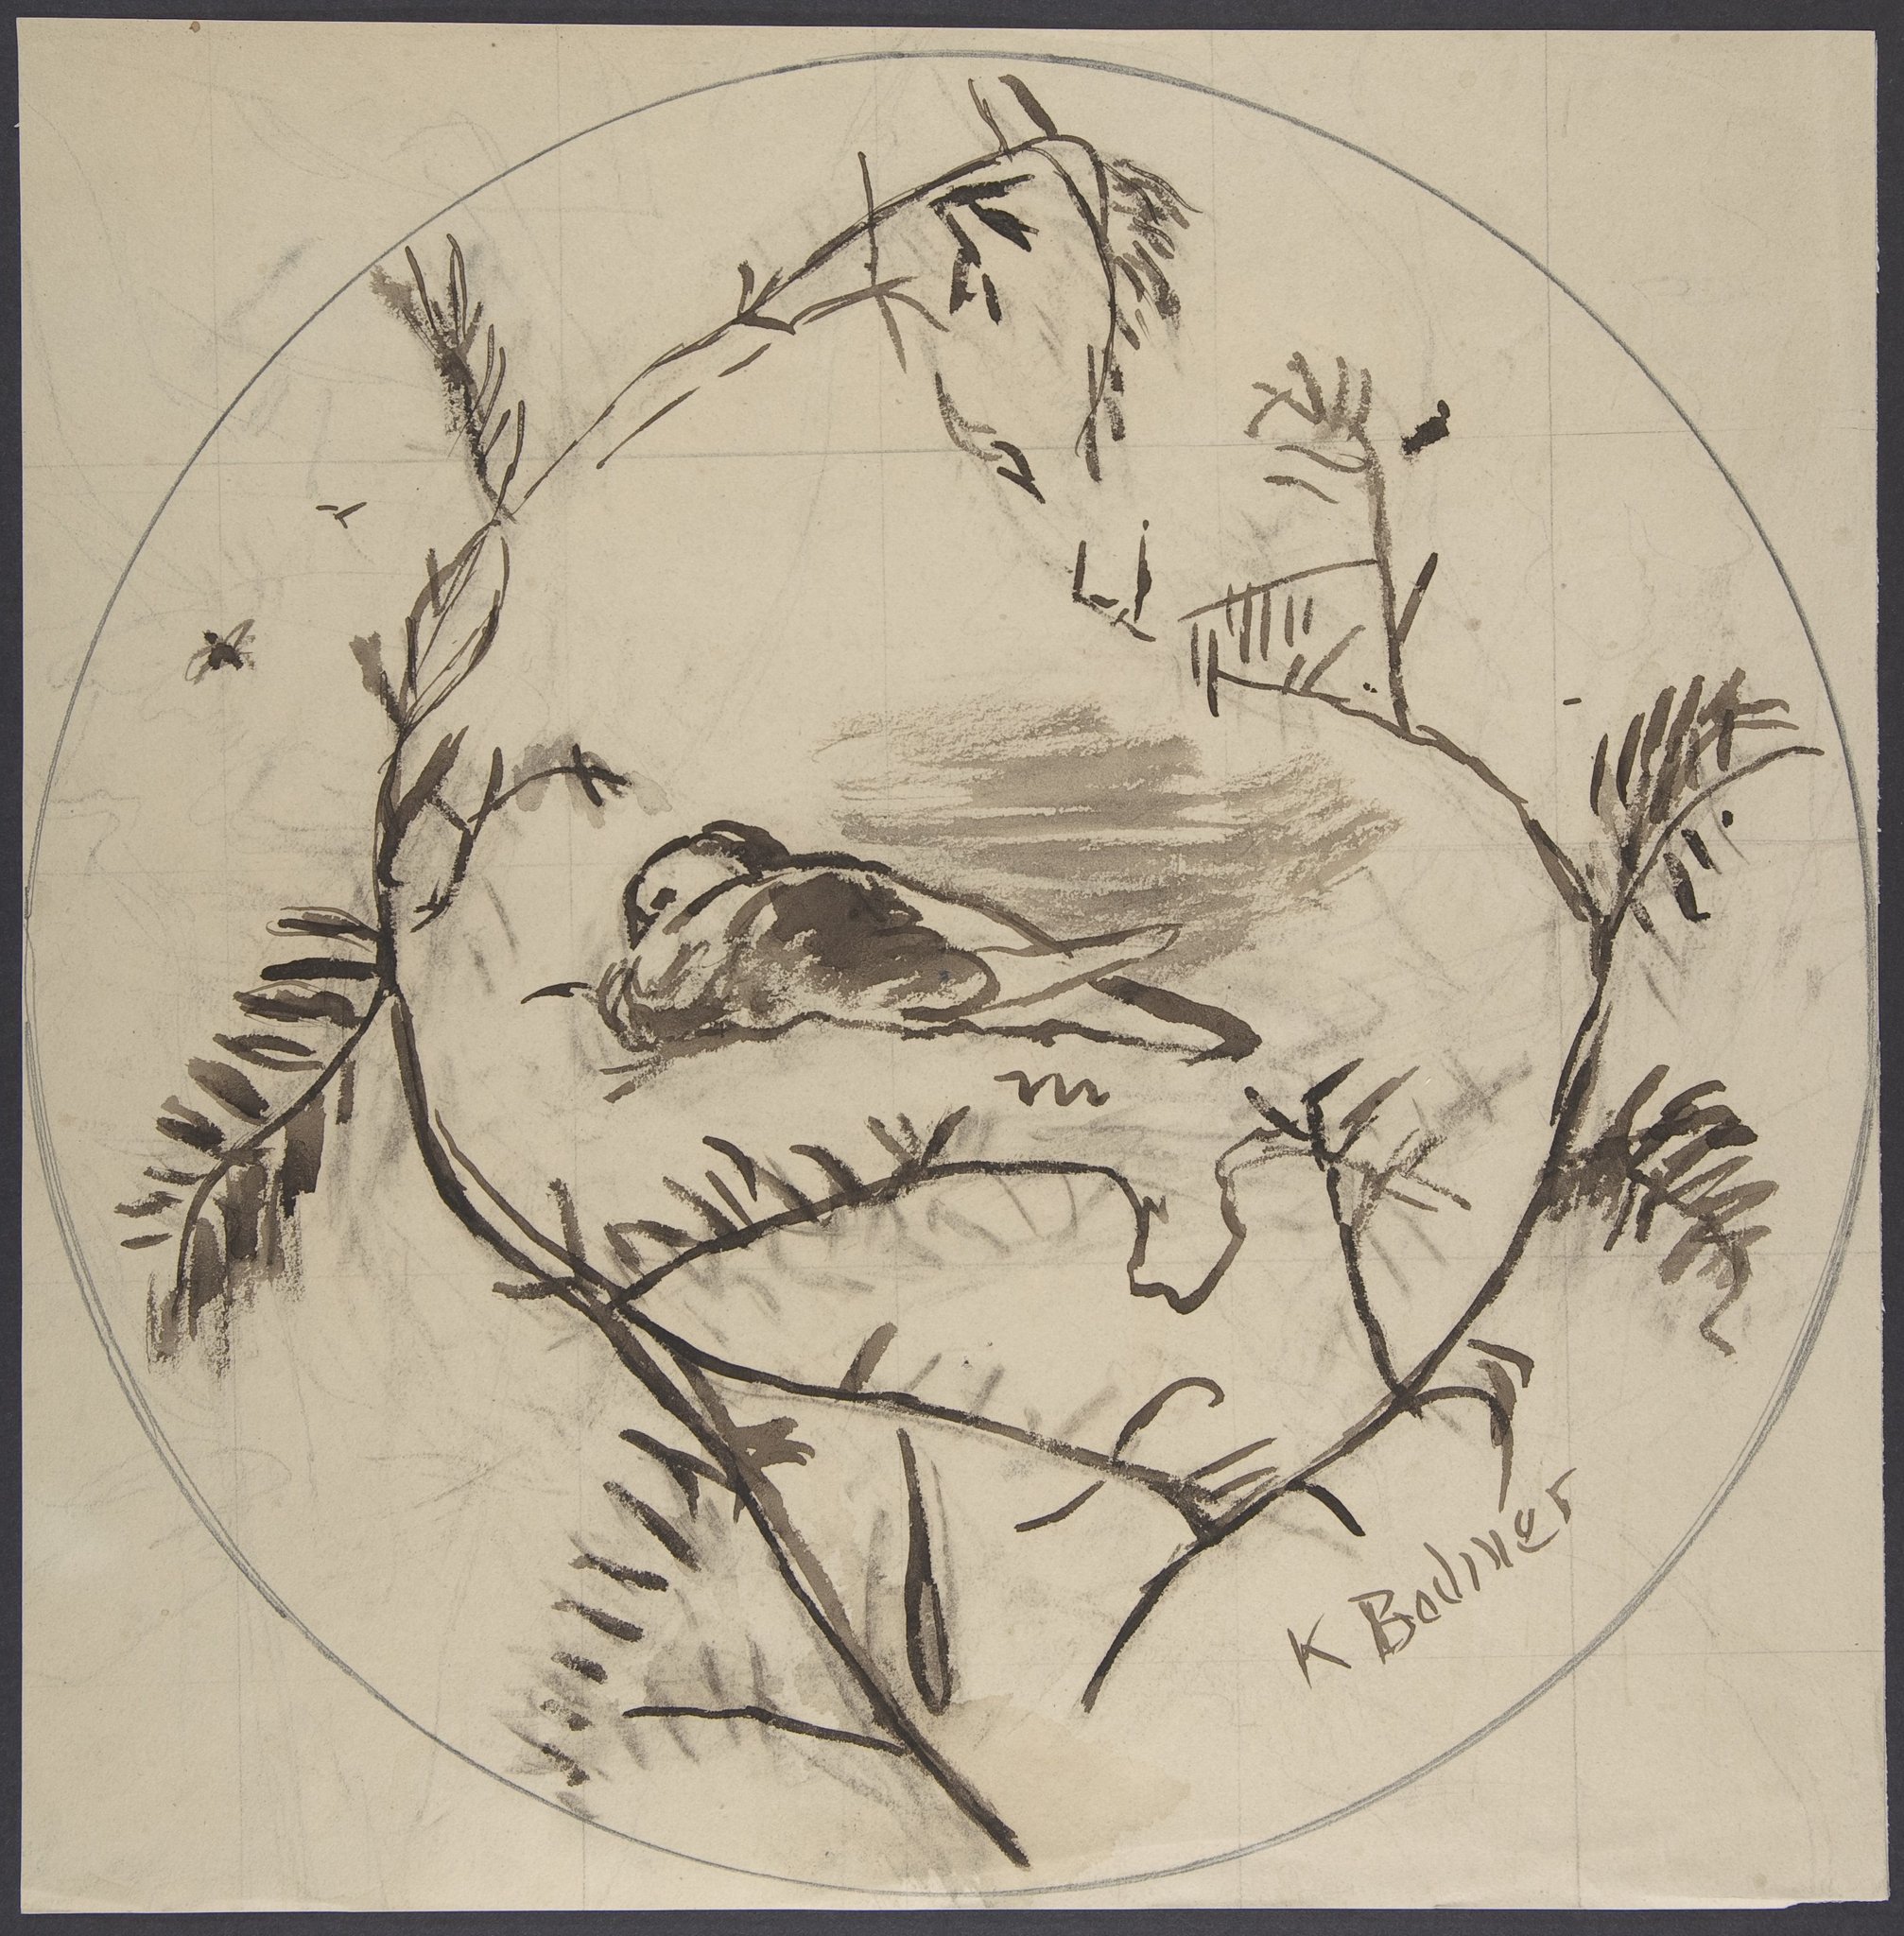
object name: drawing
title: Design for a Plate Decorated with a Bird and Plant Motifs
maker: karl bodmer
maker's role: artist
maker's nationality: swiss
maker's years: 1809-1893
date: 1825-1893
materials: graphite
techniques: brush, drawing, transfer, wash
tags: birds,plants